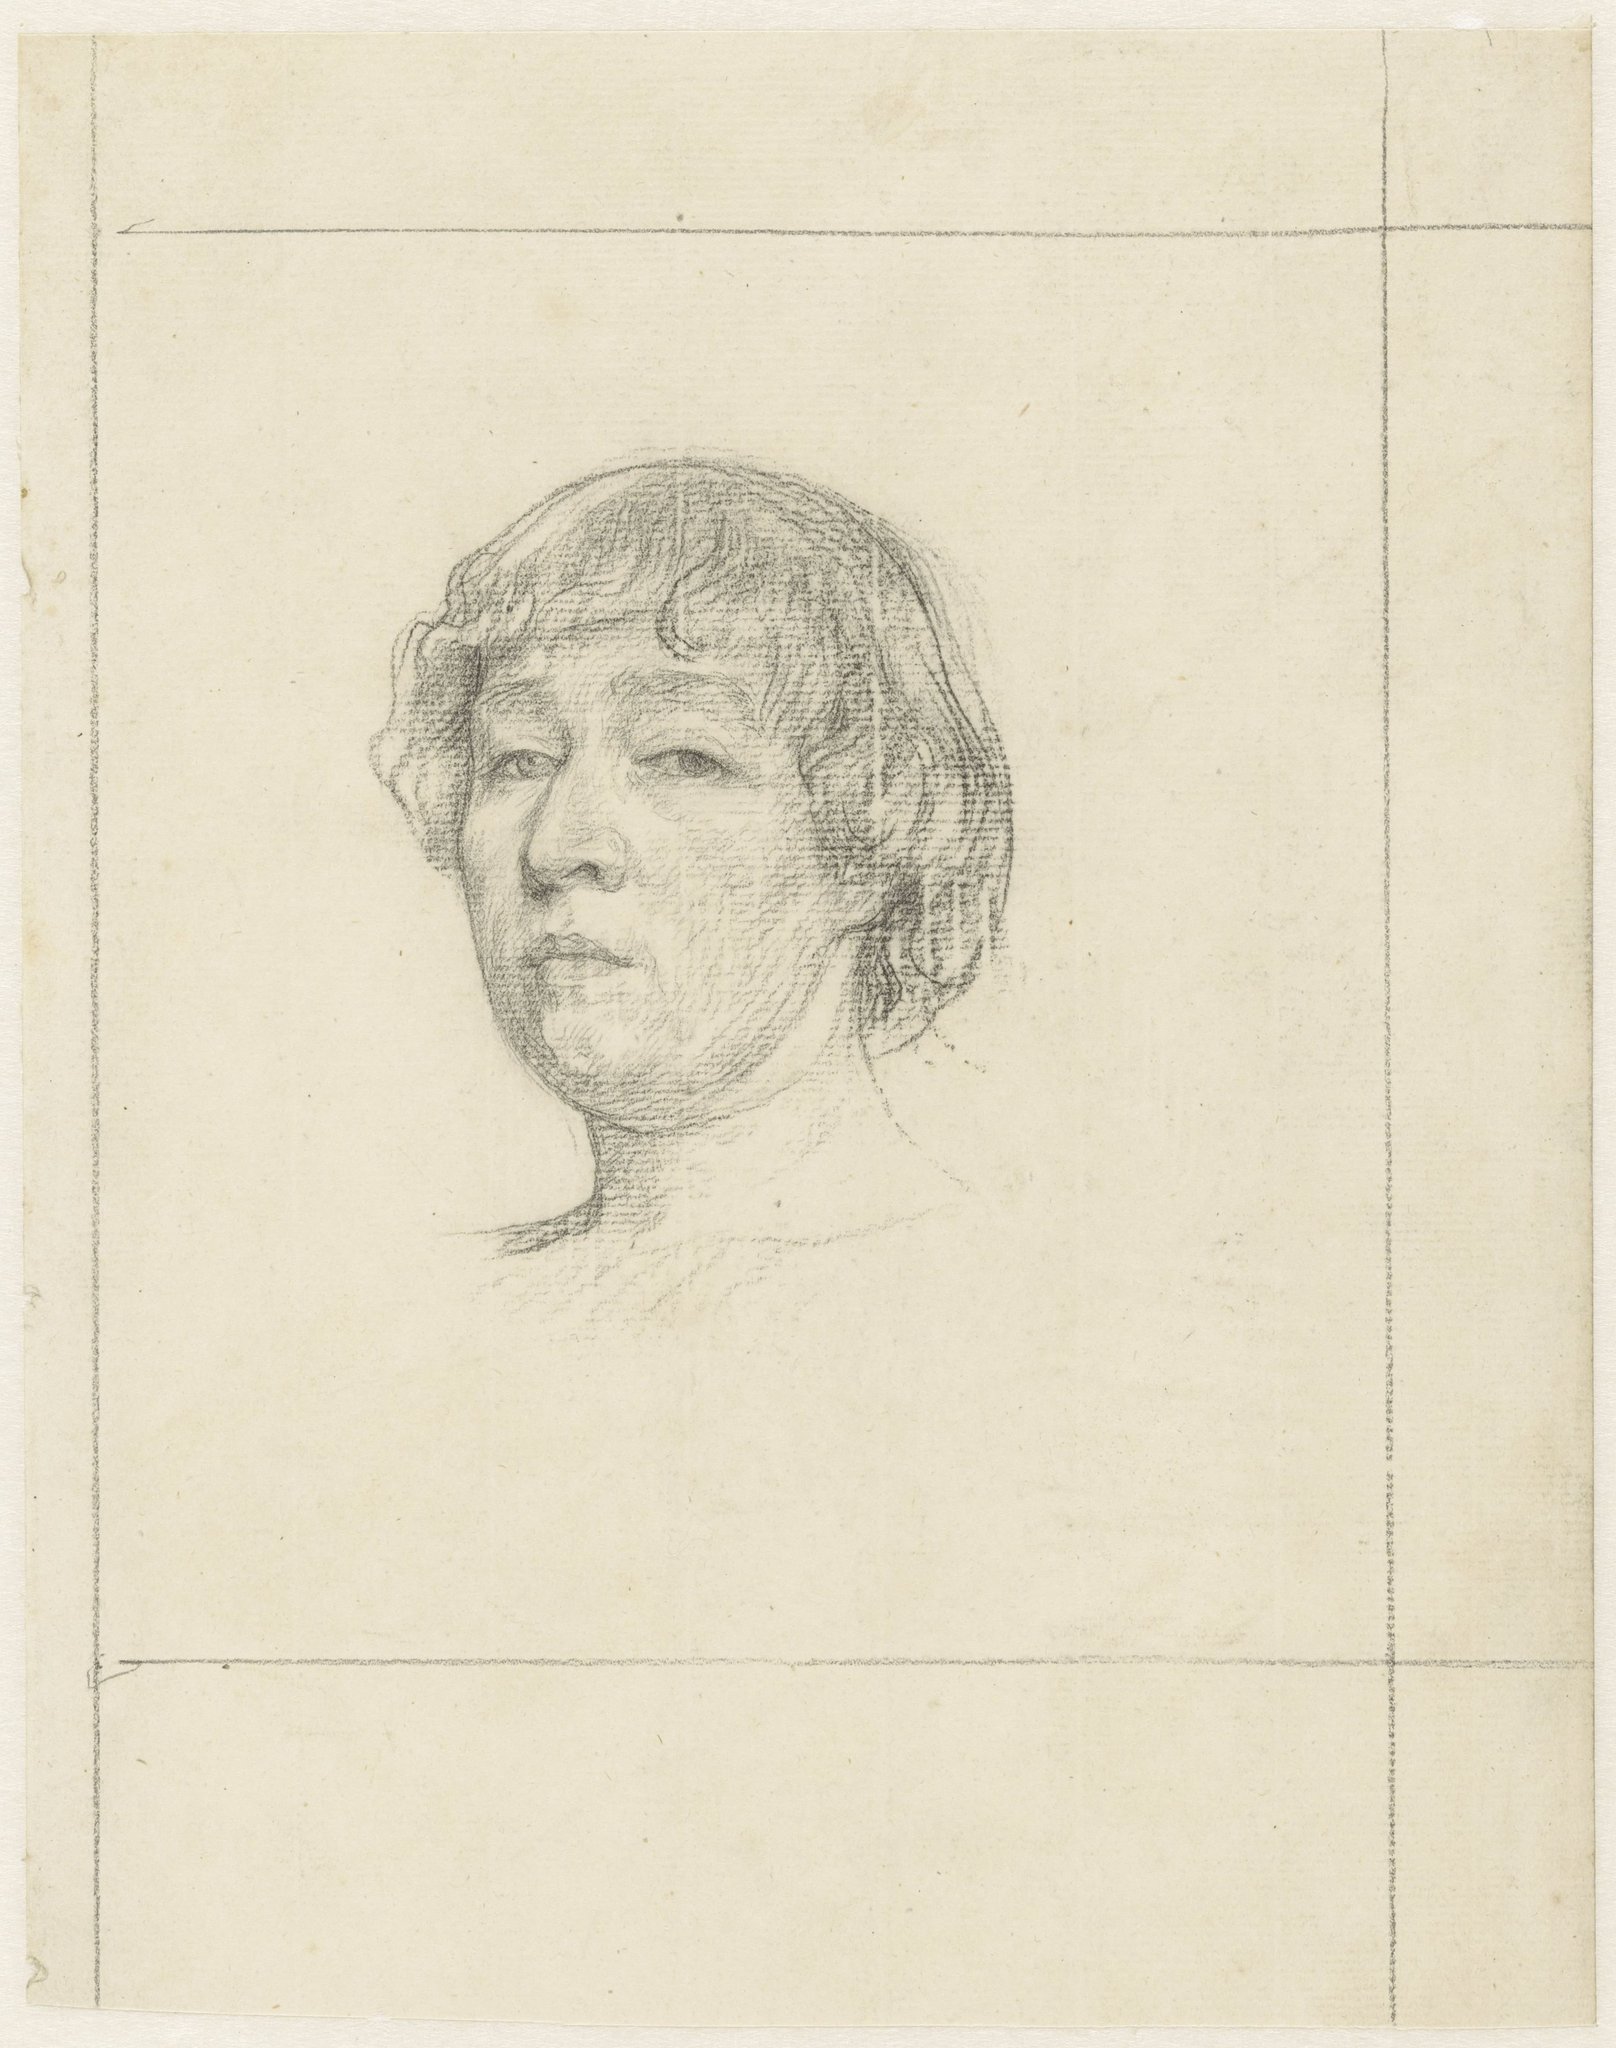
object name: drawing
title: Portret van Etha Fles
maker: jan veth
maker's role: designer, draughtsman, painter, print maker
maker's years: 1864-1925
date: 1886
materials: chalk, paper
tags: utrecht, etha fles, historical persons